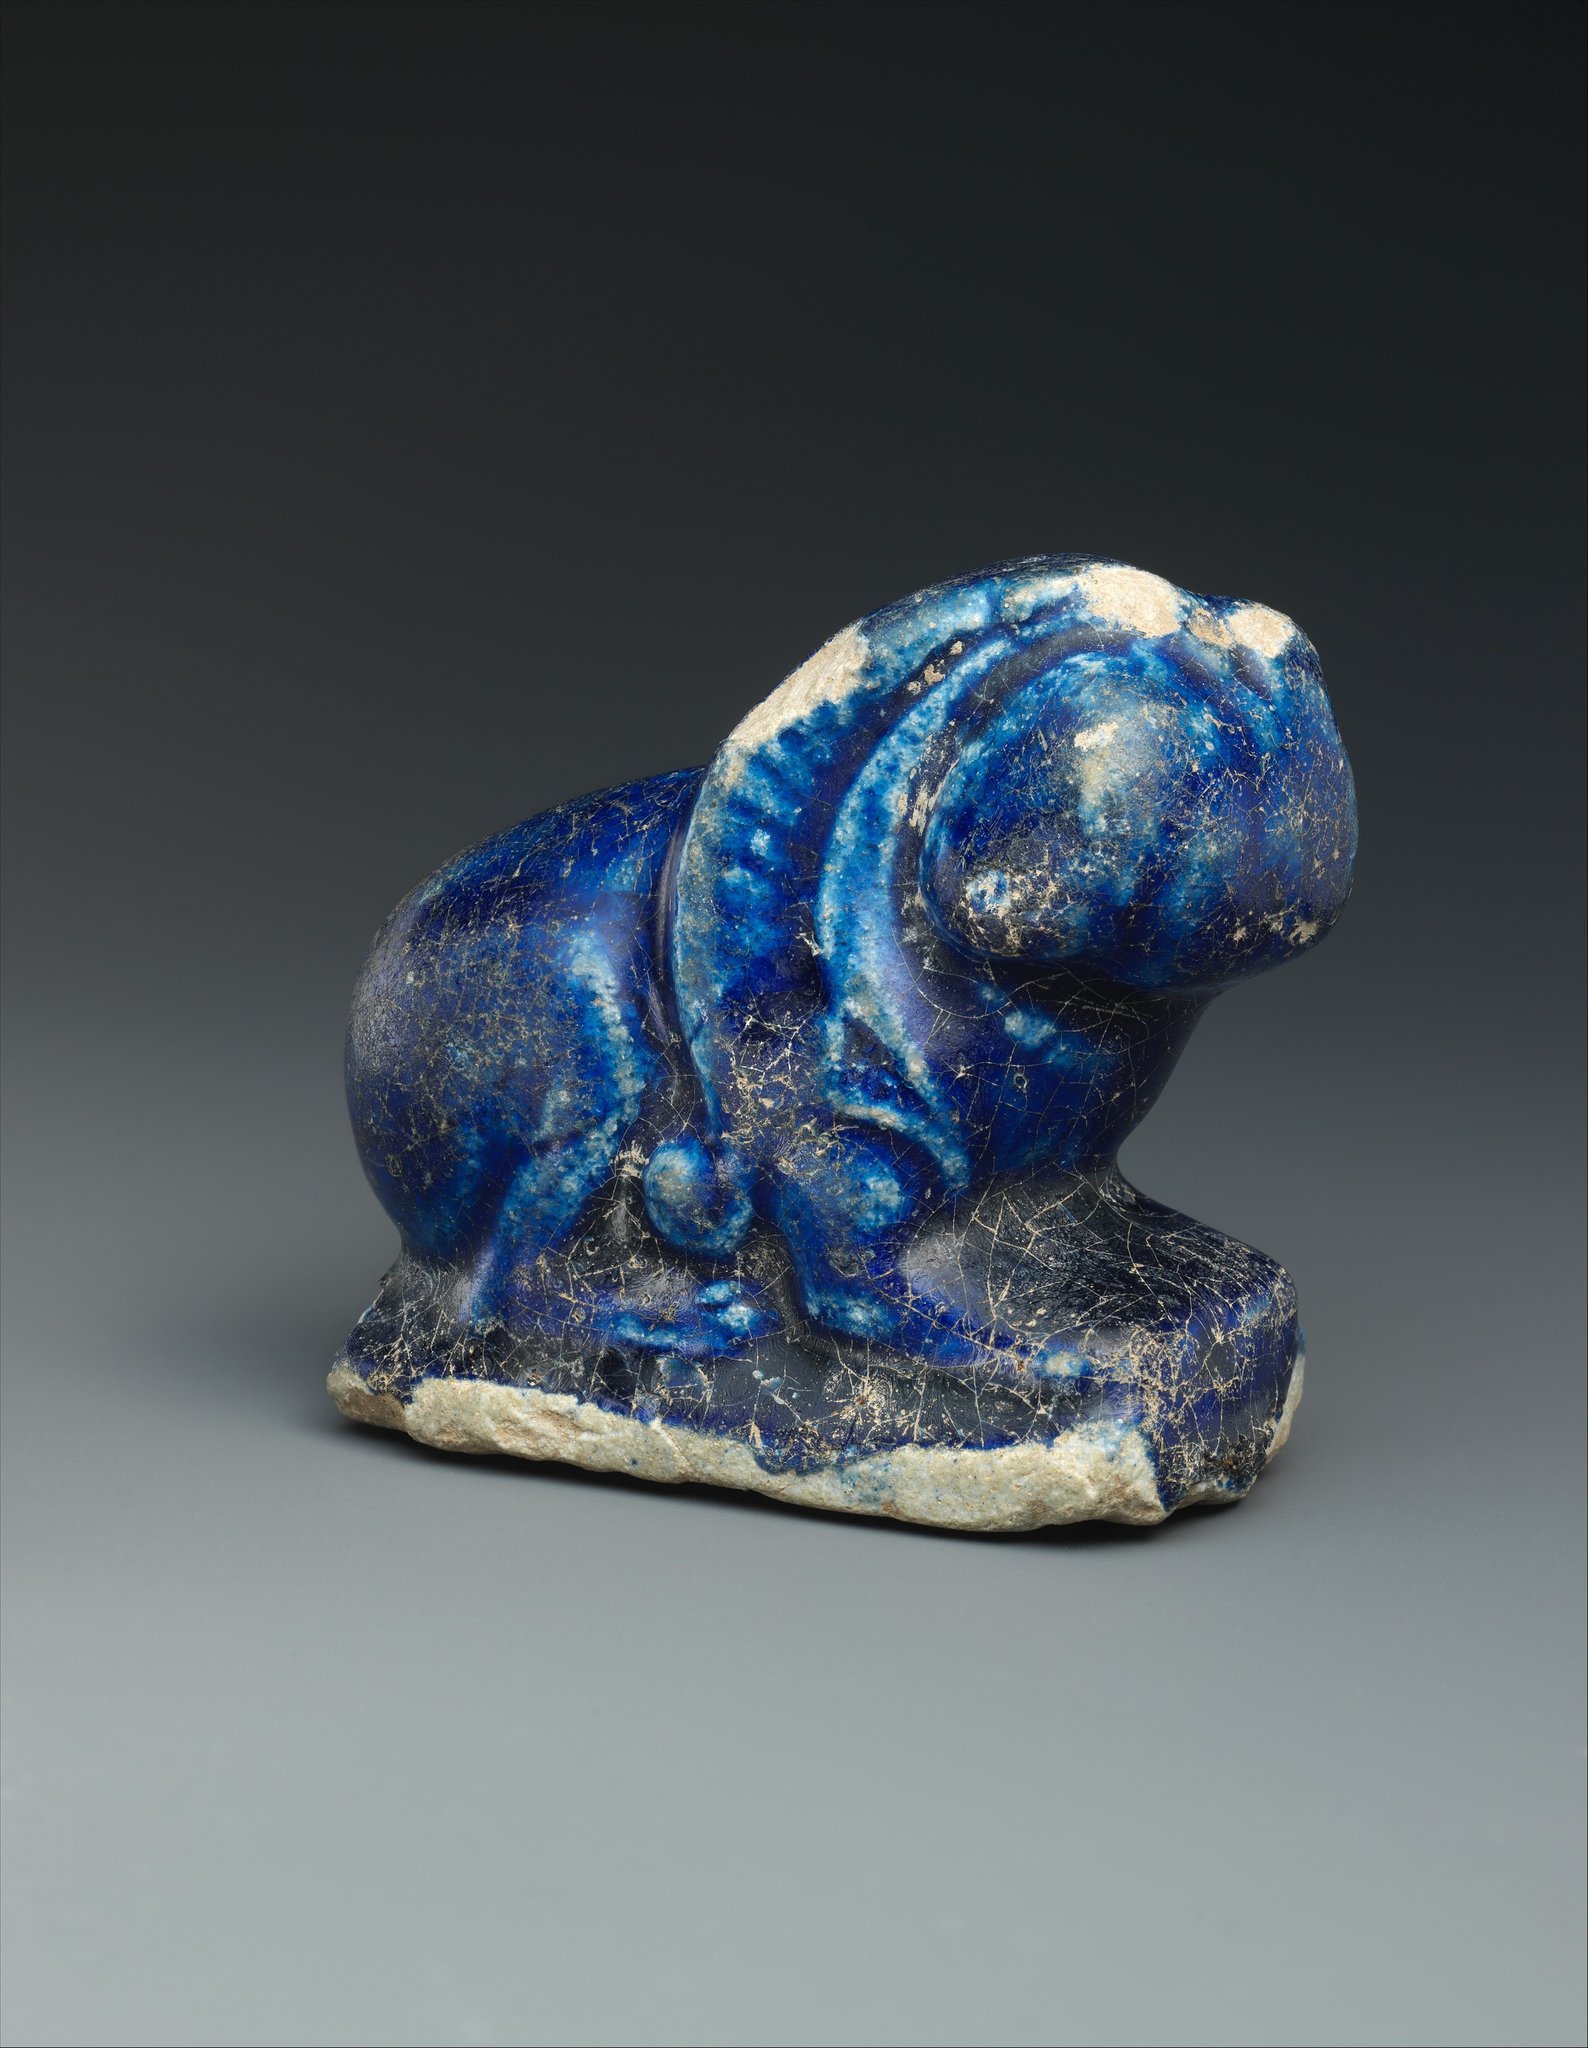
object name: bath scraper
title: Bath Scraper in the Shape of a Lion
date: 1067-1200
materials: stonepaste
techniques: glazing, incising, molding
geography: iran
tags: lions